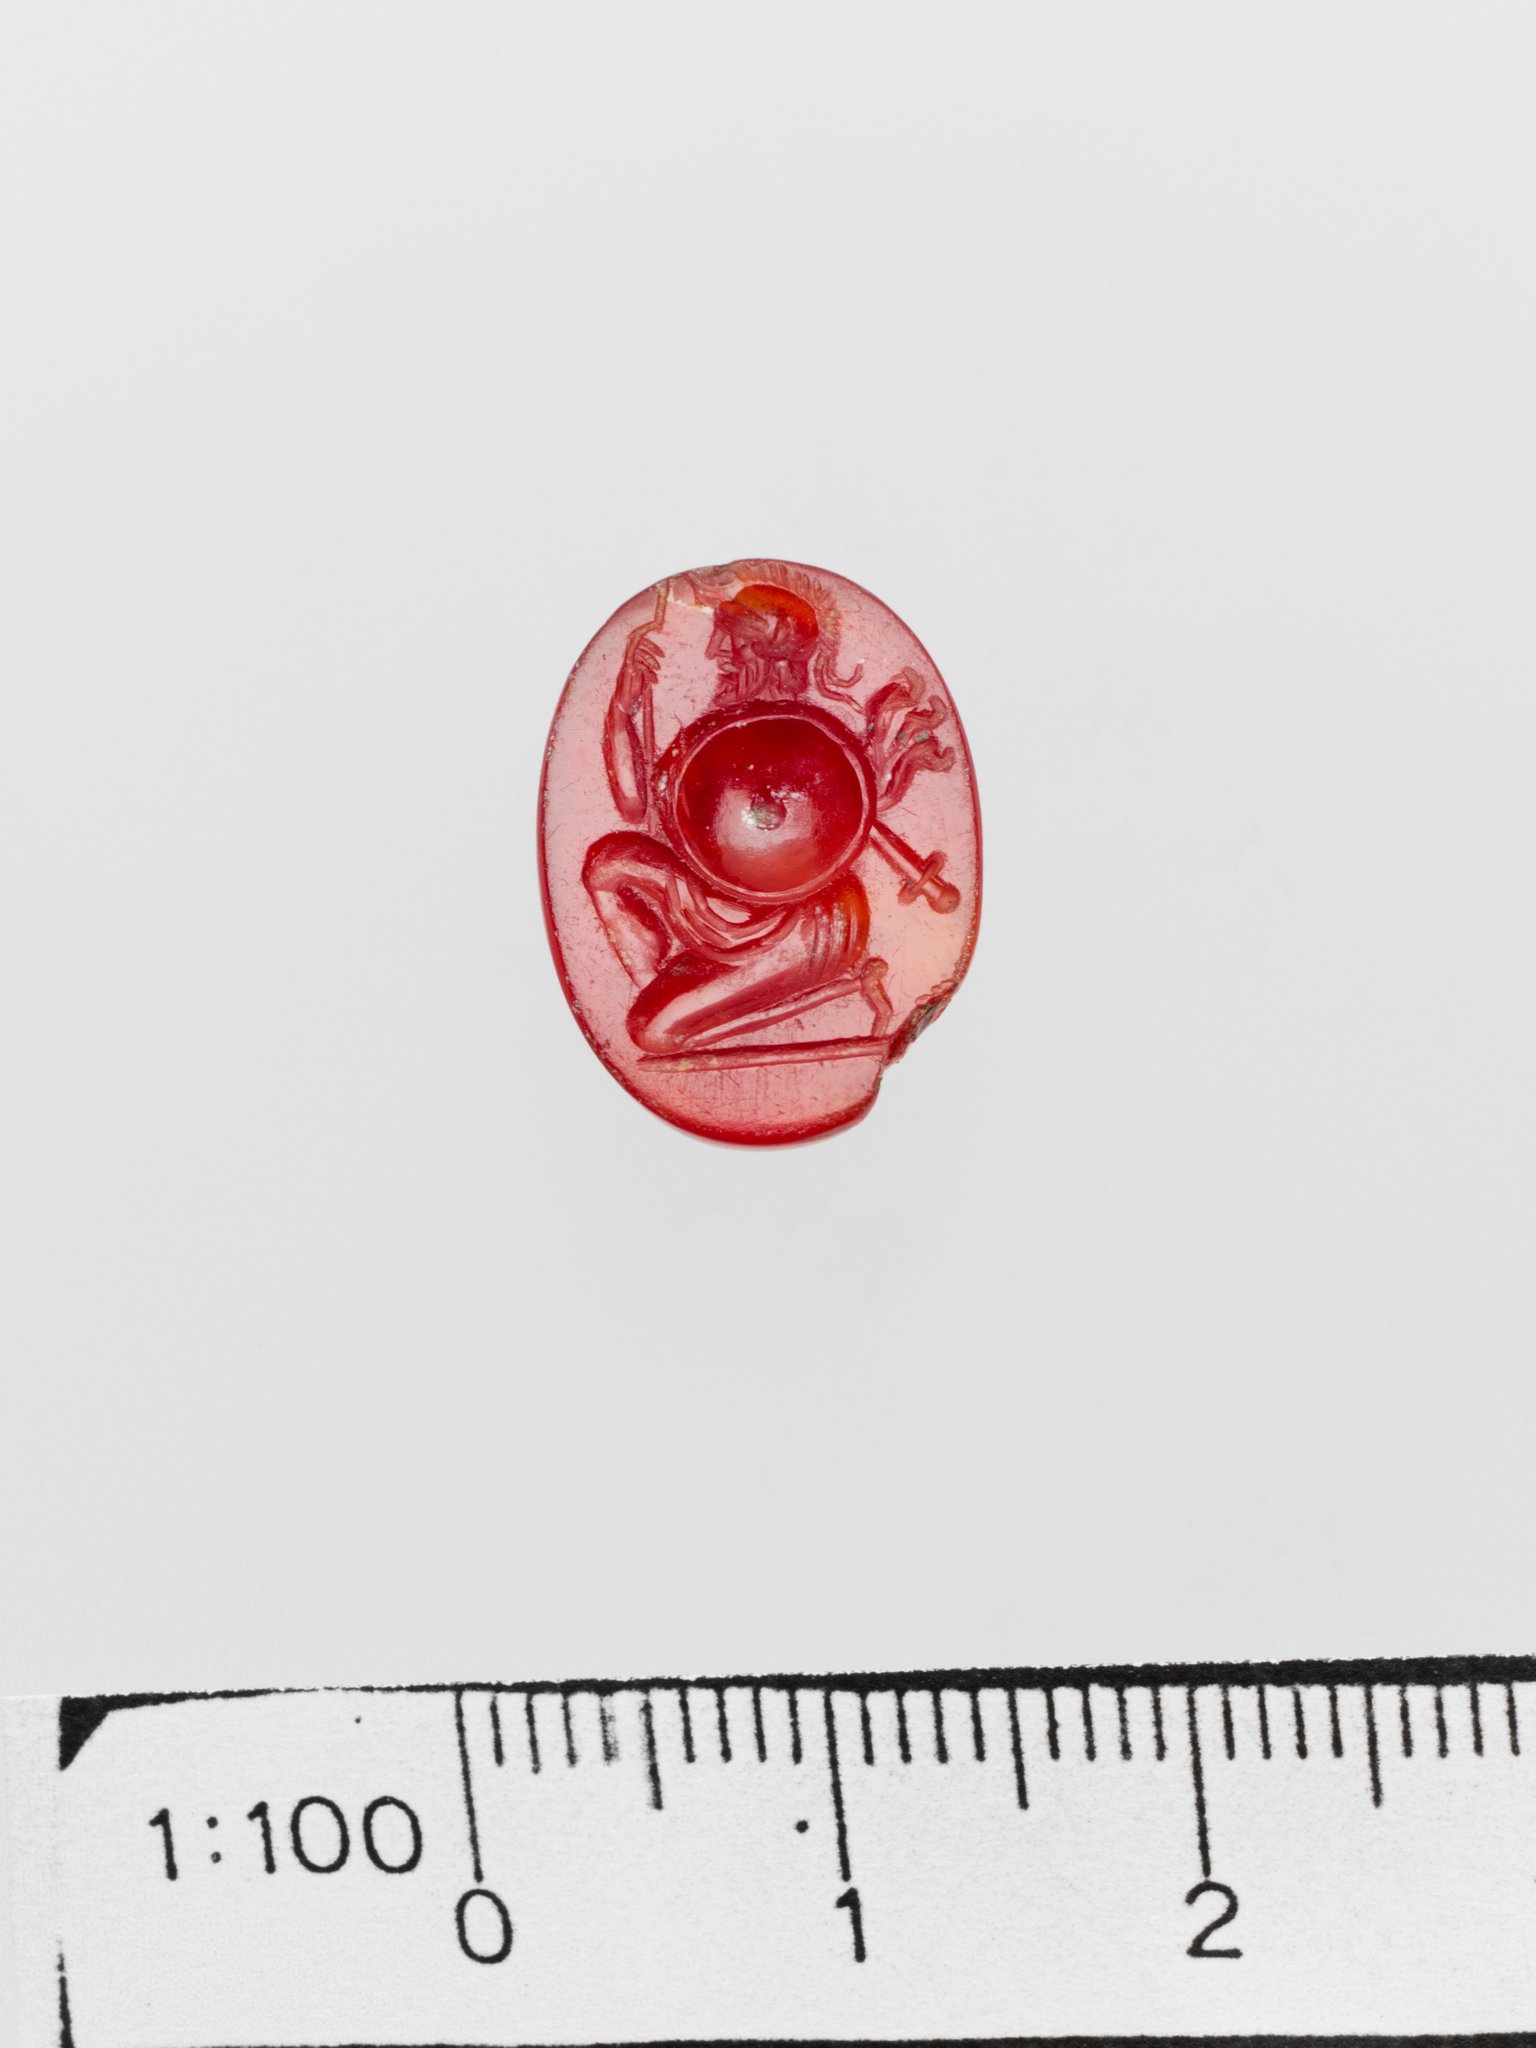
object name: intaglio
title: Carnelian ring stone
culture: italic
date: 300-101 BCE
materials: gemstone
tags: helmets,shields,men,warriors